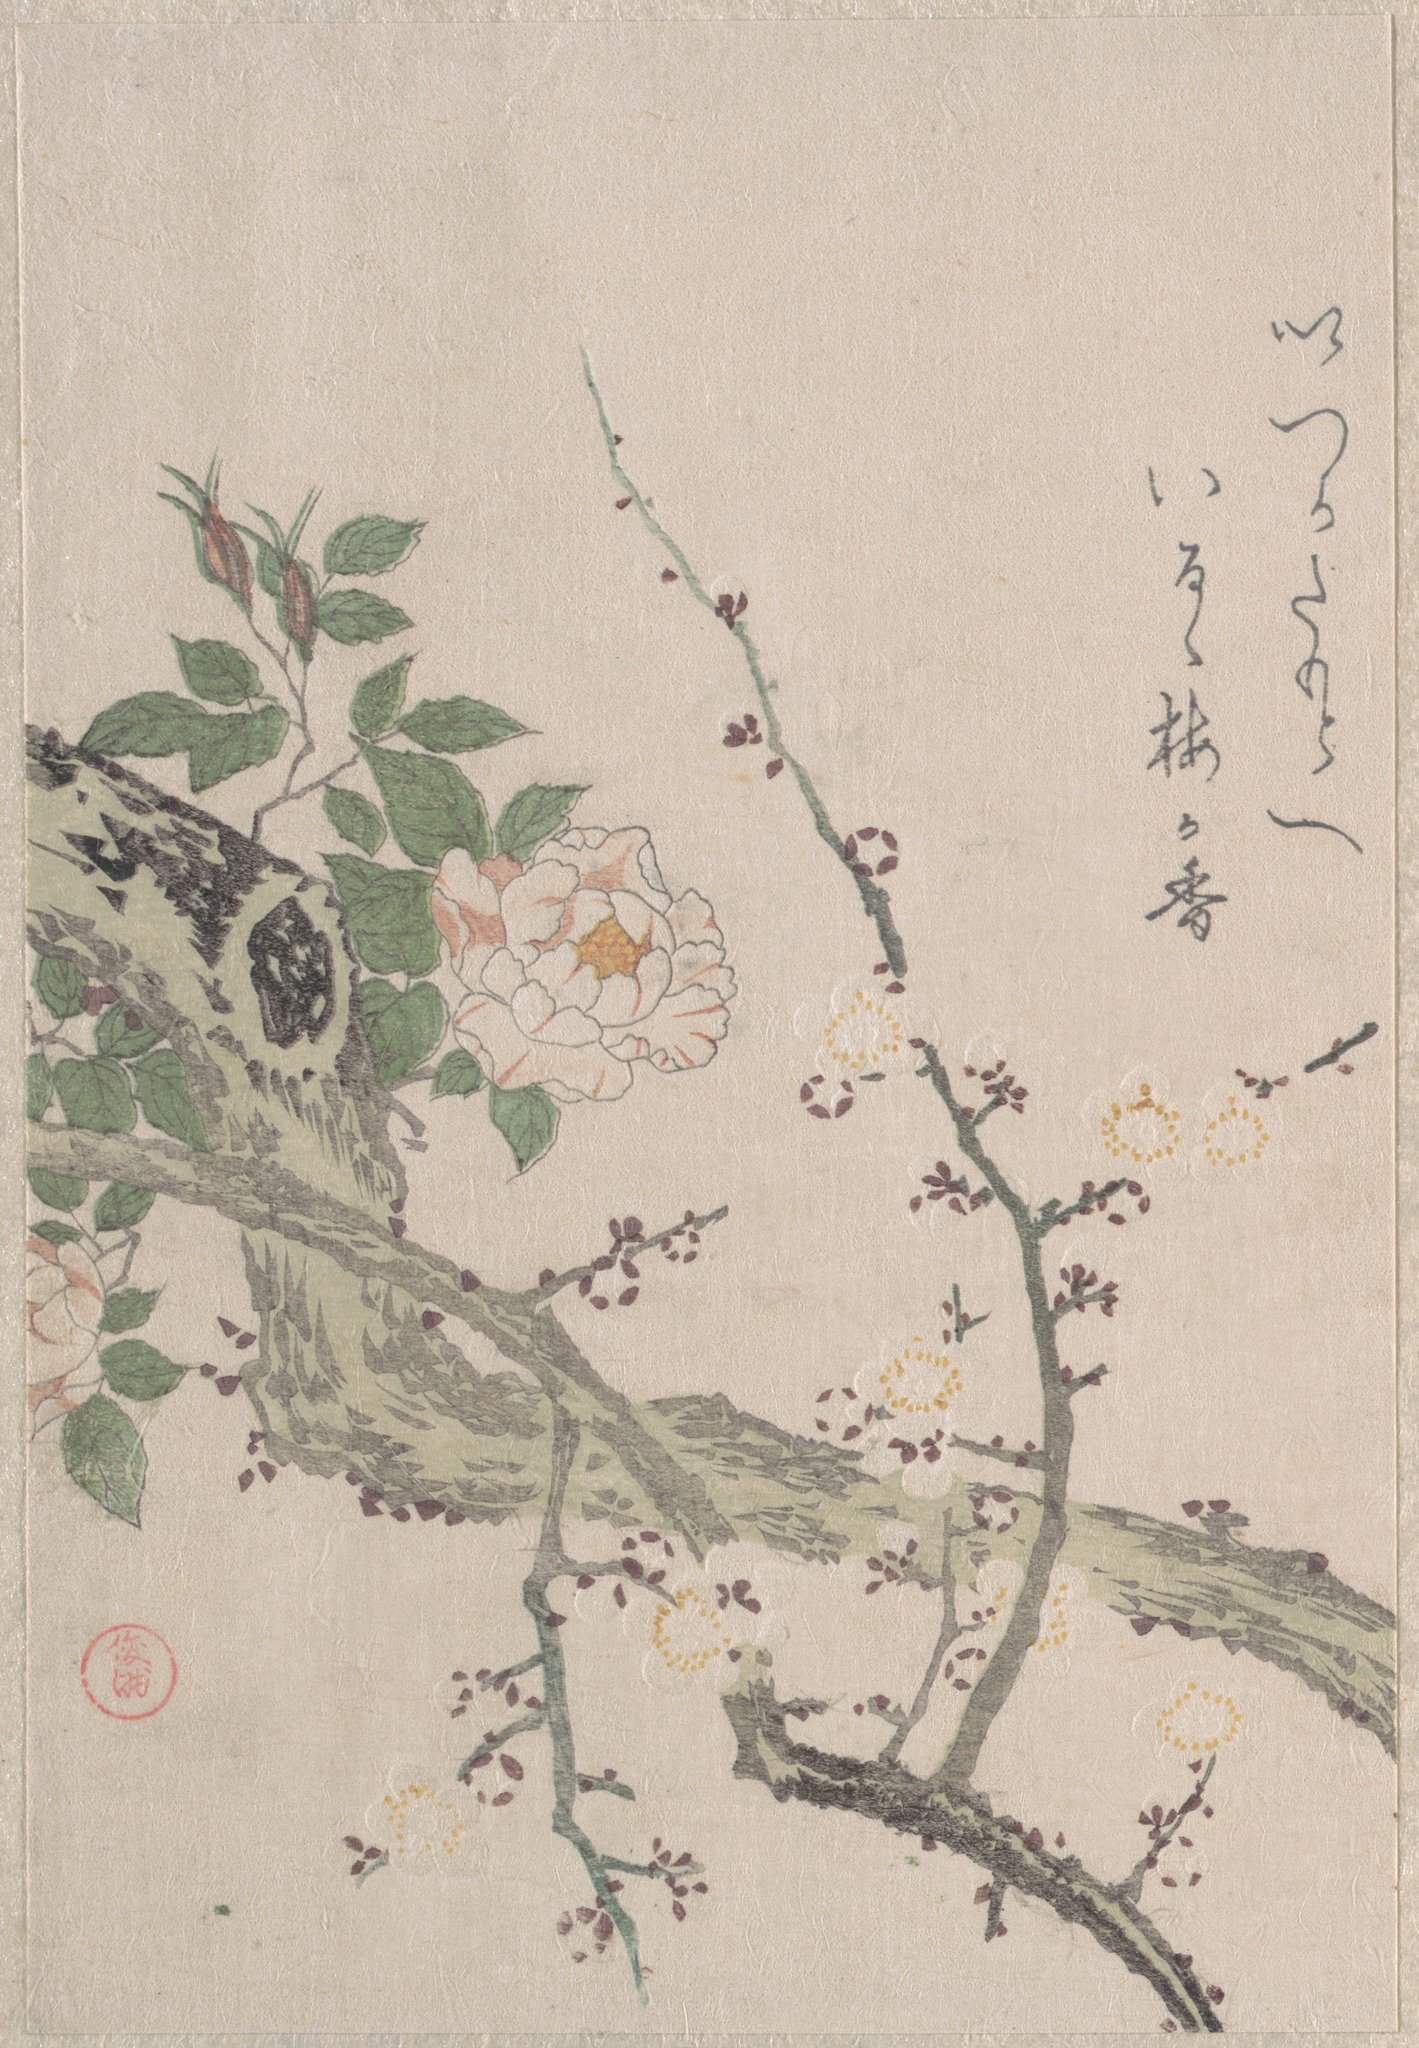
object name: print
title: Roses and Plum Blossoms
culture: japanese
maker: kubo shunman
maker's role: artist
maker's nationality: japanese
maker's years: 1757-1820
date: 1801-1900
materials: ink, paper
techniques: surimono, woodblock print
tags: flowers,roses,leaves